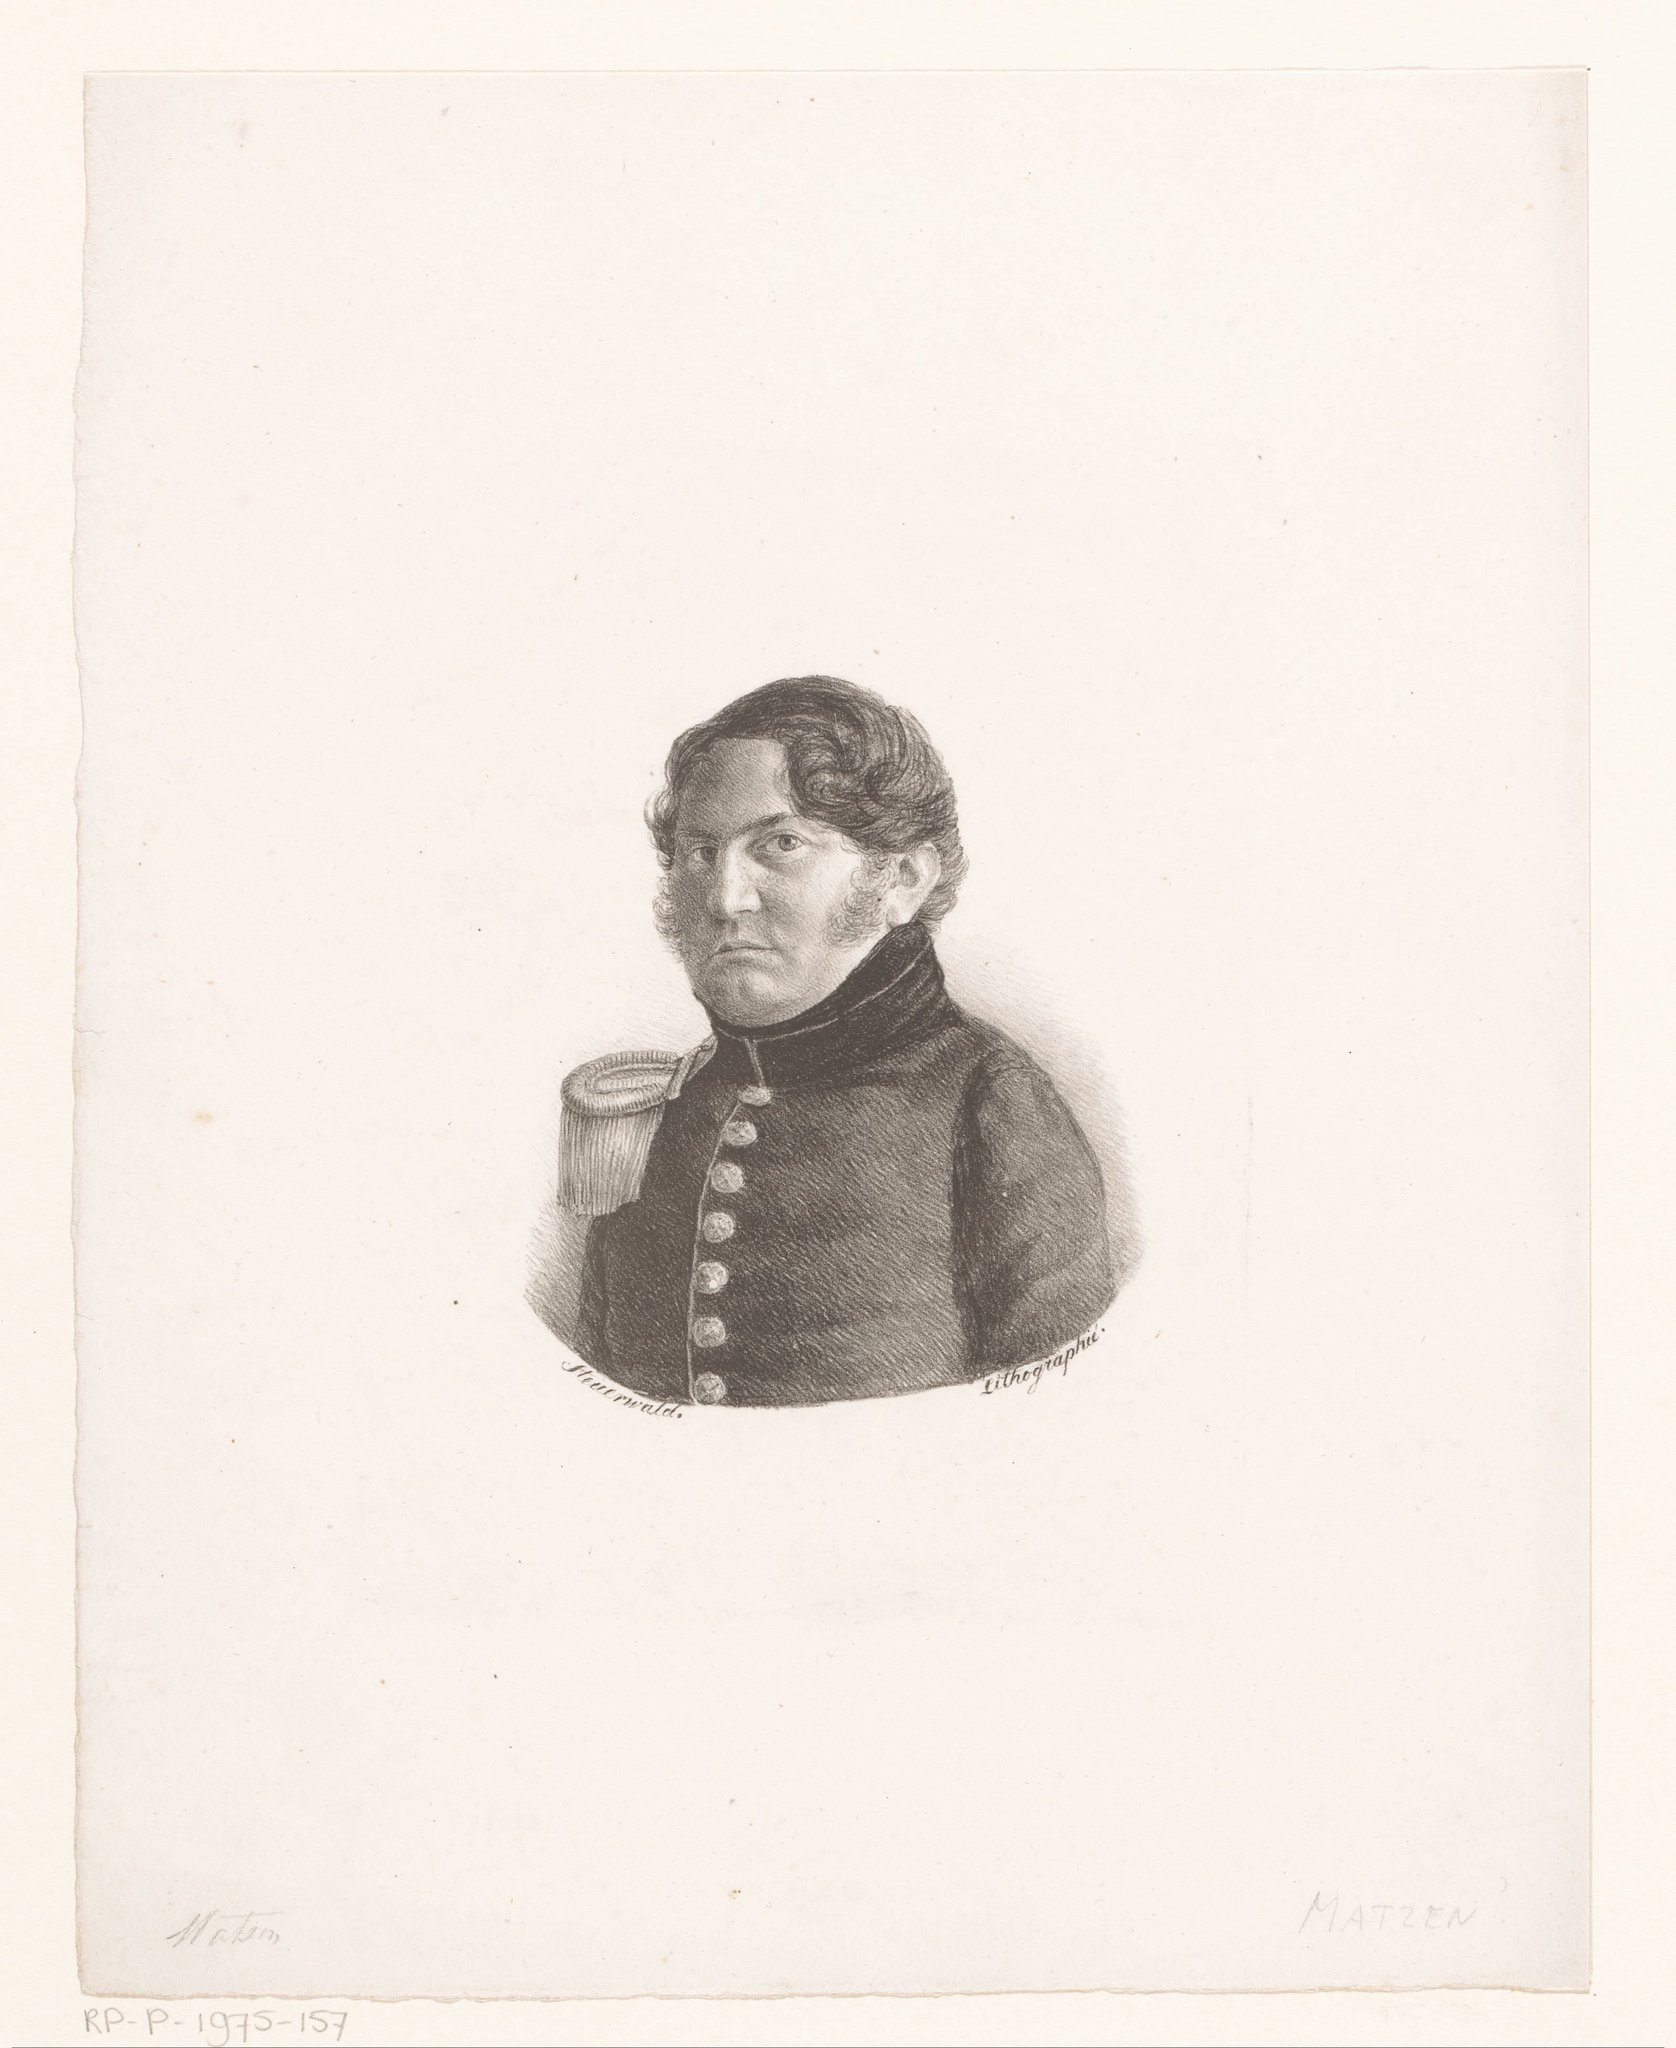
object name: print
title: Portret van onbekende militair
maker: christian heinrich gottlieb steuerwald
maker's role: draughtsman, print maker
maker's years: 1802-1874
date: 1822-1874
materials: paper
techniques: lithograph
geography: dordrecht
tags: anonymous historical person portrayed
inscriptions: collector's mark: Lugt 2228, inscription: ‘4a / 10-9-'75’